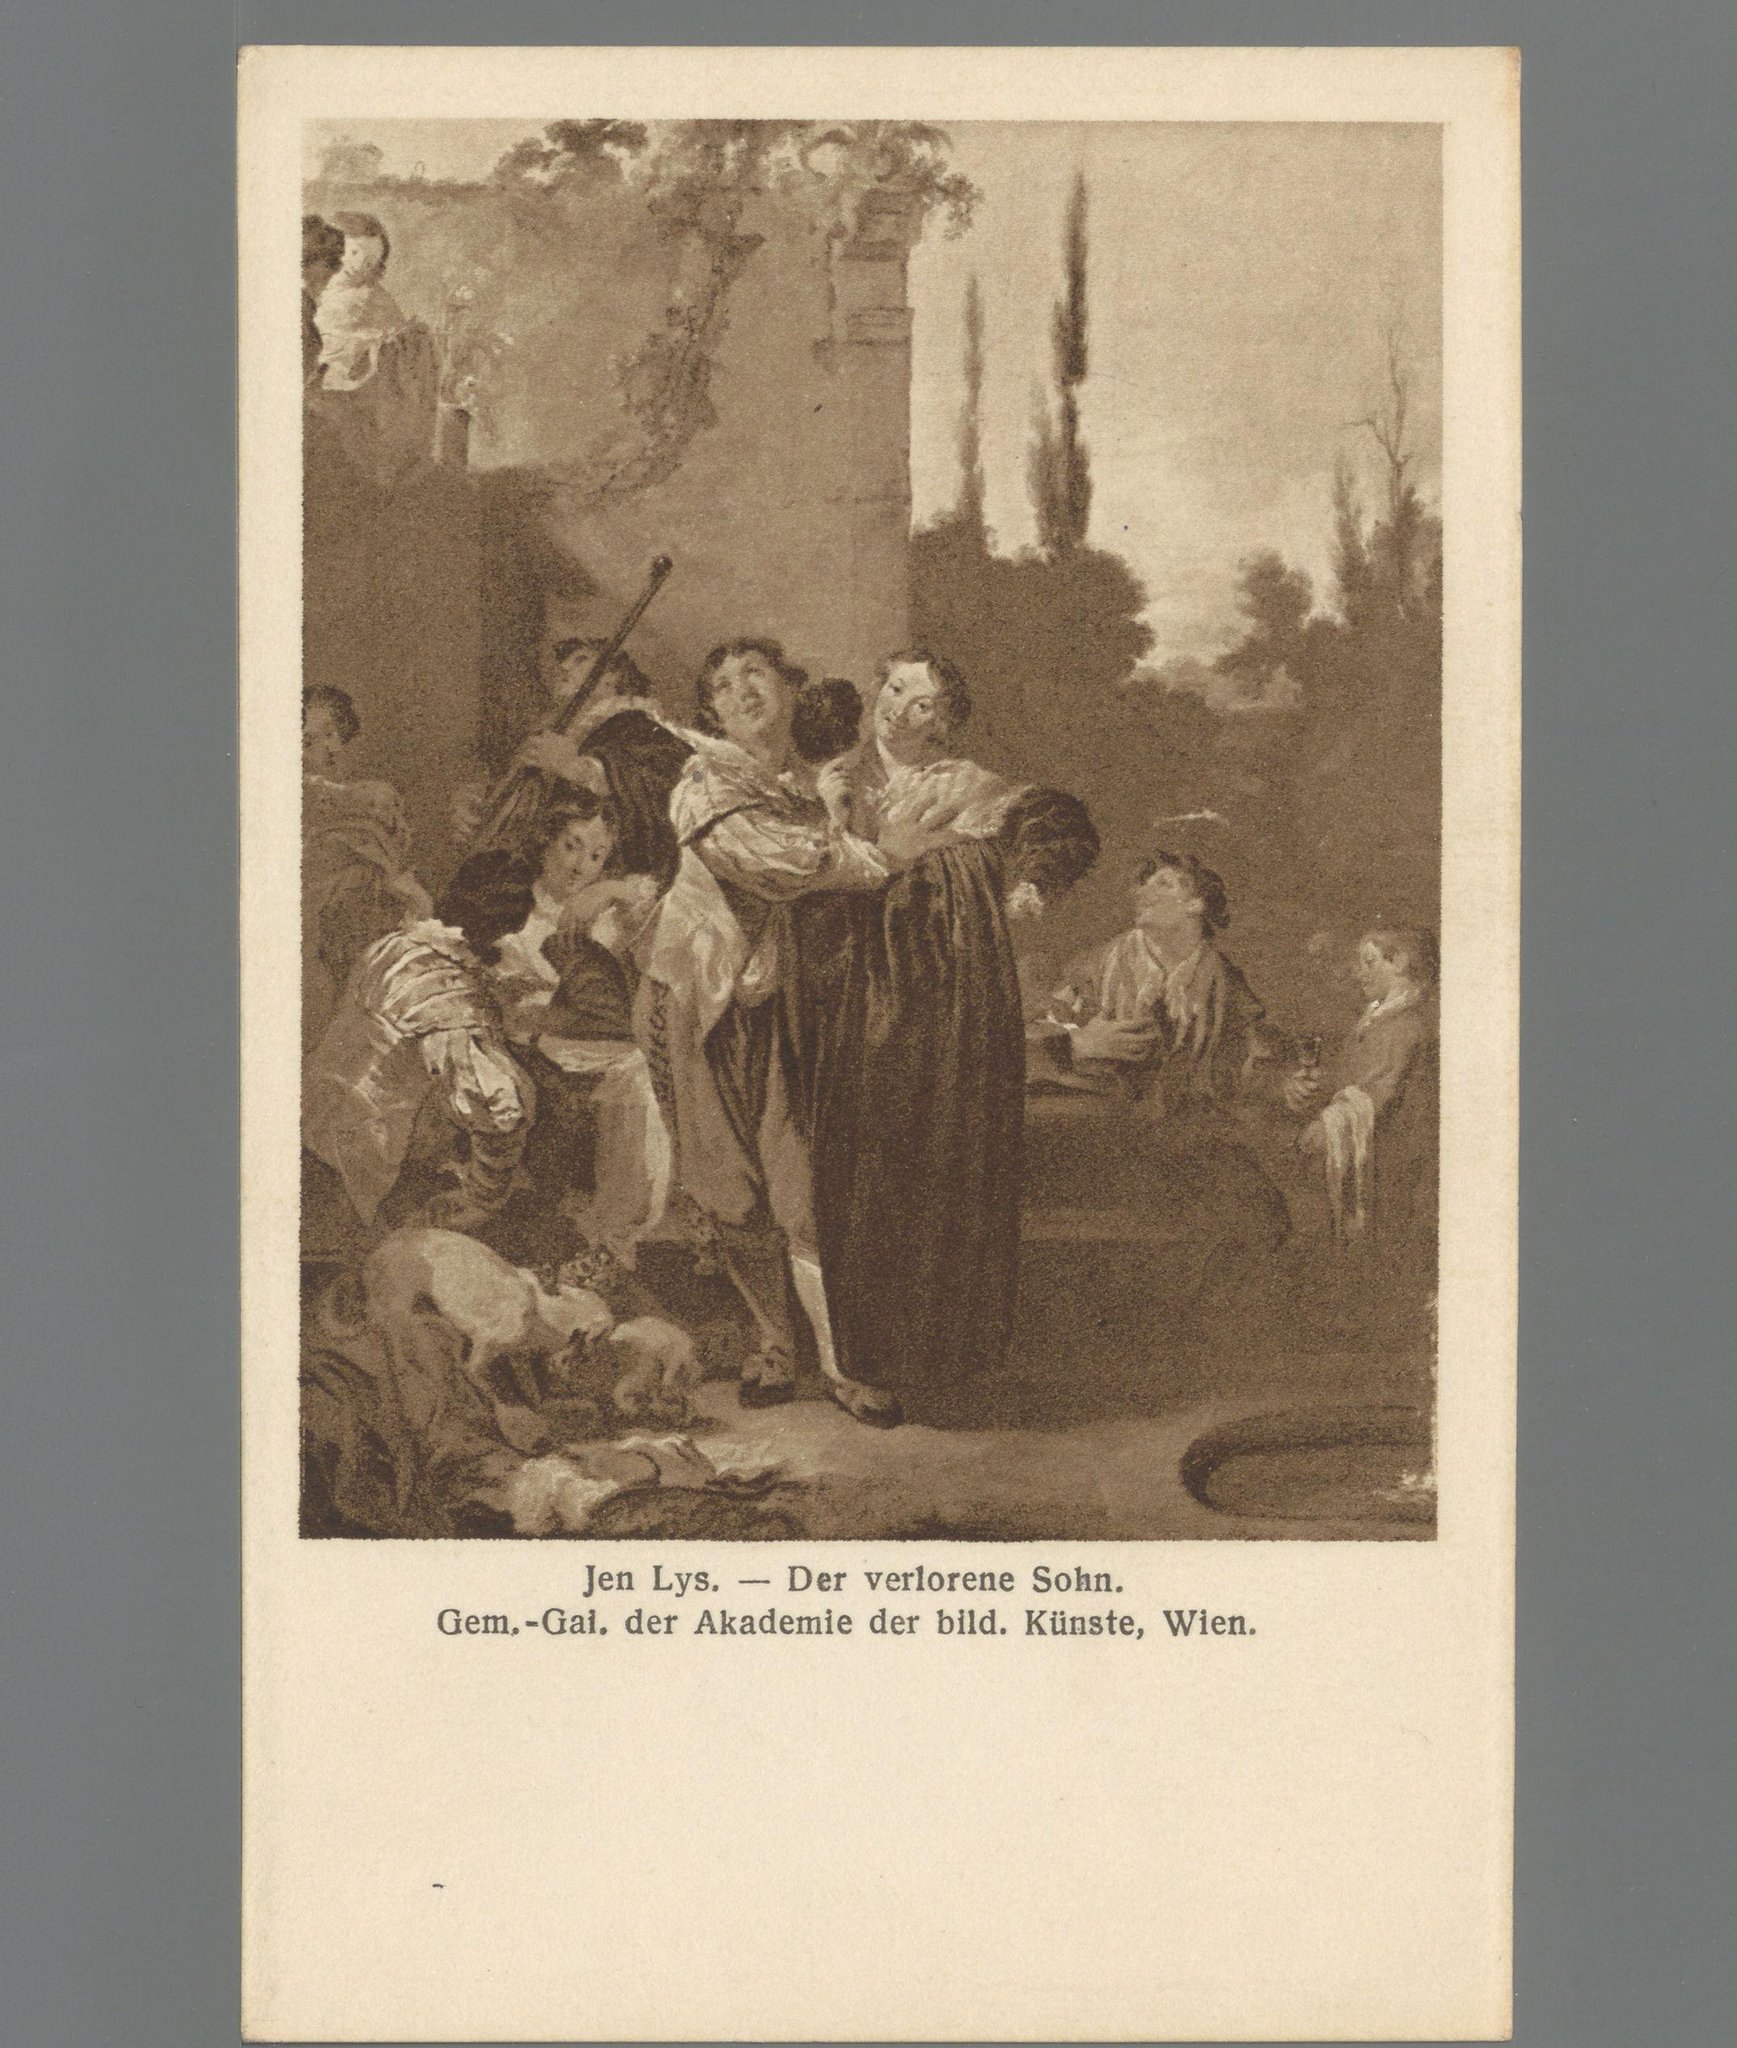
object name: ansichtkaart, prentbriefkaart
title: Jen Lys. Der verlorene Sohn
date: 1905-1930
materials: cardboard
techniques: rotogravure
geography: vienna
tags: recreation, the parable of the prodigal son (luke 15:11-32)